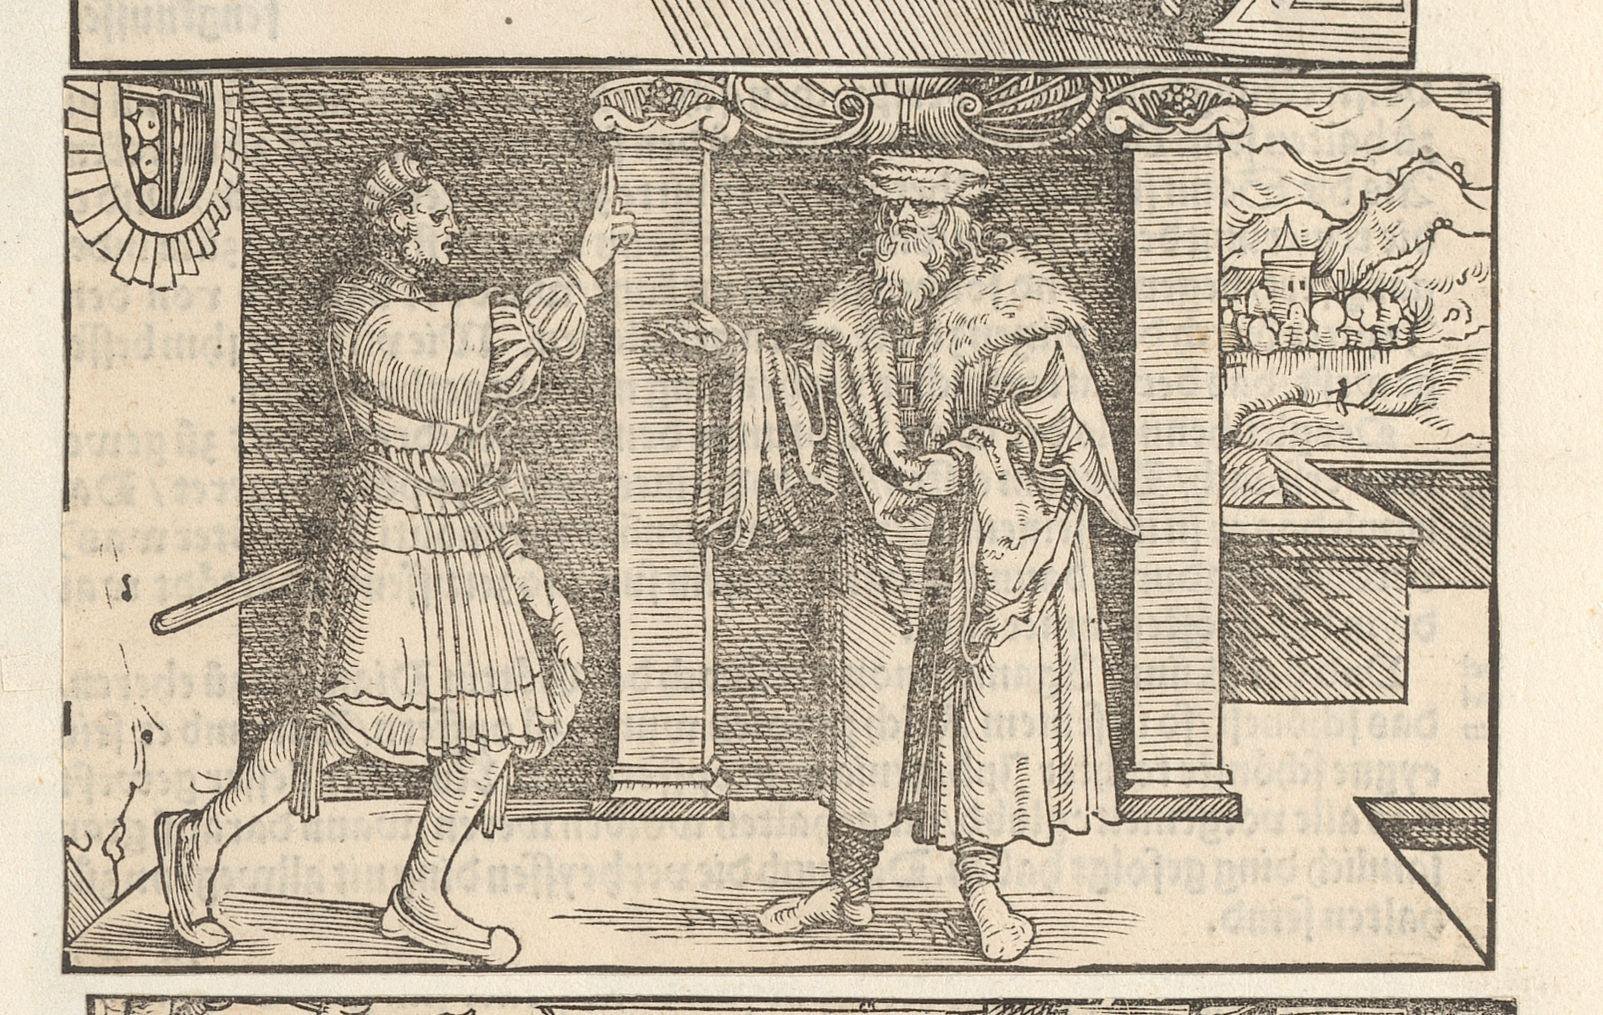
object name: book illustration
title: Twee debatterende mannen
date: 1514-1531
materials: paper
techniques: letterpress printing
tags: debate, discussion (~ meeting)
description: Deze prent is gebruikt in: Cicero, Marcus Tulius. Officia M.T.C. Ein Buch so Marcus Tullius Cicero der Römer zu seynem (...). [Vertaald uit het Latijn door] Johann von Schwarzenberg. Augsburg: Heinrich Steiner, 1531.